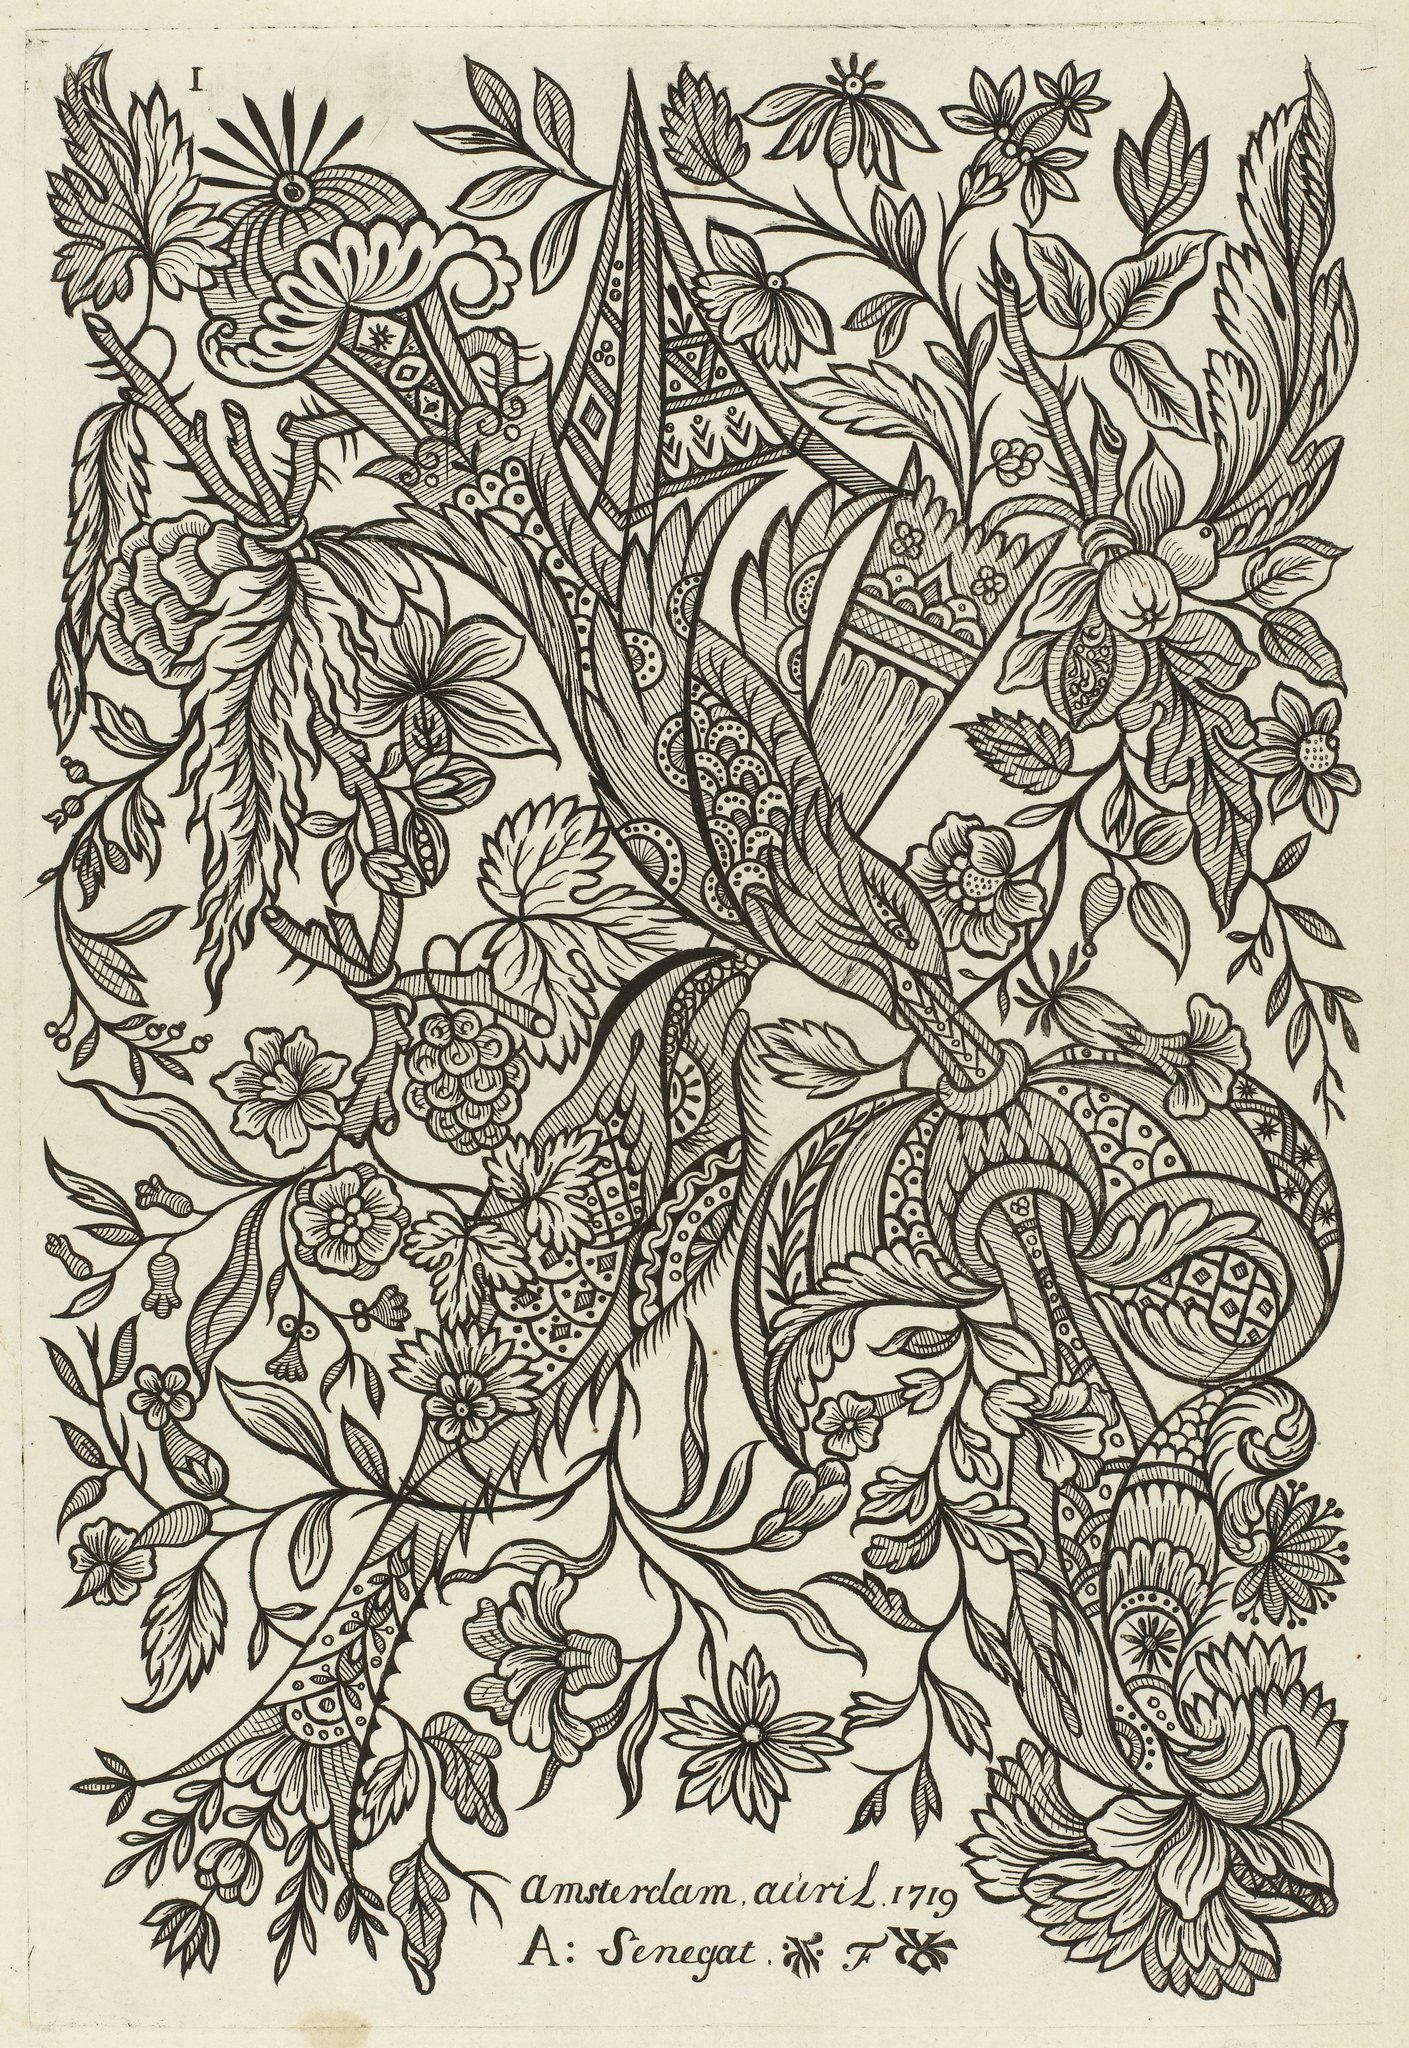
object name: ornament print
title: Ontwerp voor textiel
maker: alexander senegat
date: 1704-1719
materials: paper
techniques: etching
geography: amsterdam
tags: artist (in general) making preliminary designs, sketching, textile industry and clothing industry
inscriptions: collector's mark: Lugt 2228, collector's mark: Lugt 2760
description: Ontwerp voor textiel met fantasiebloemen en -bladeren.